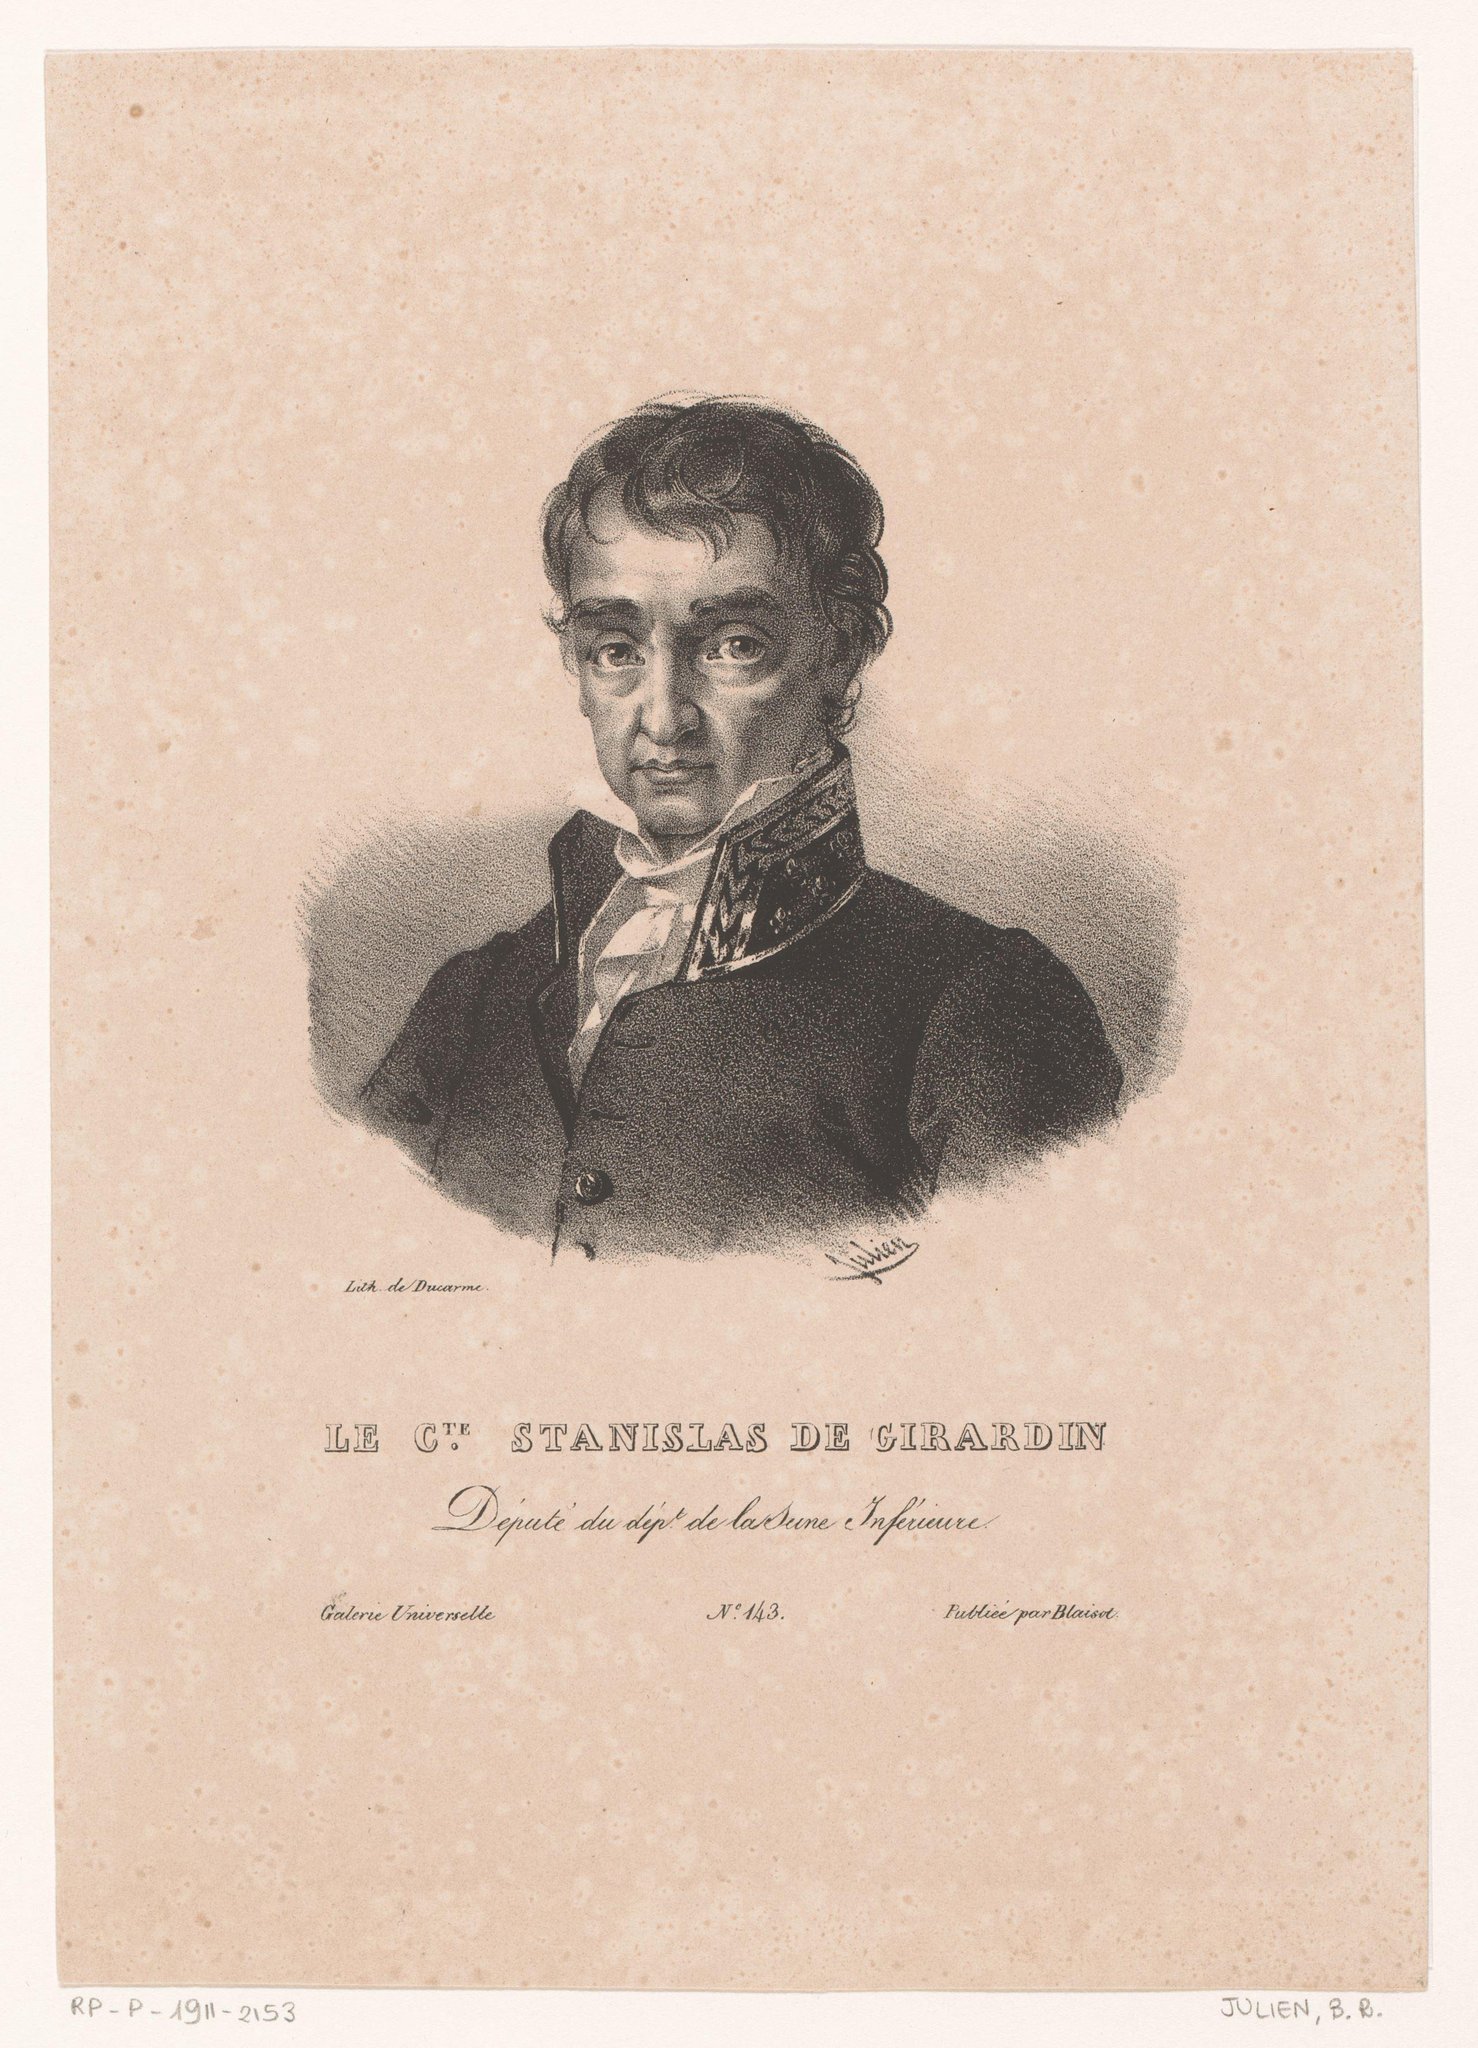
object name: print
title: Portrettengalerij van Blaisot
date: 1827-1830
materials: paper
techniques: lithograph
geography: paris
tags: paris, politician, historical persons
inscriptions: collector's mark: Lugt 2228a